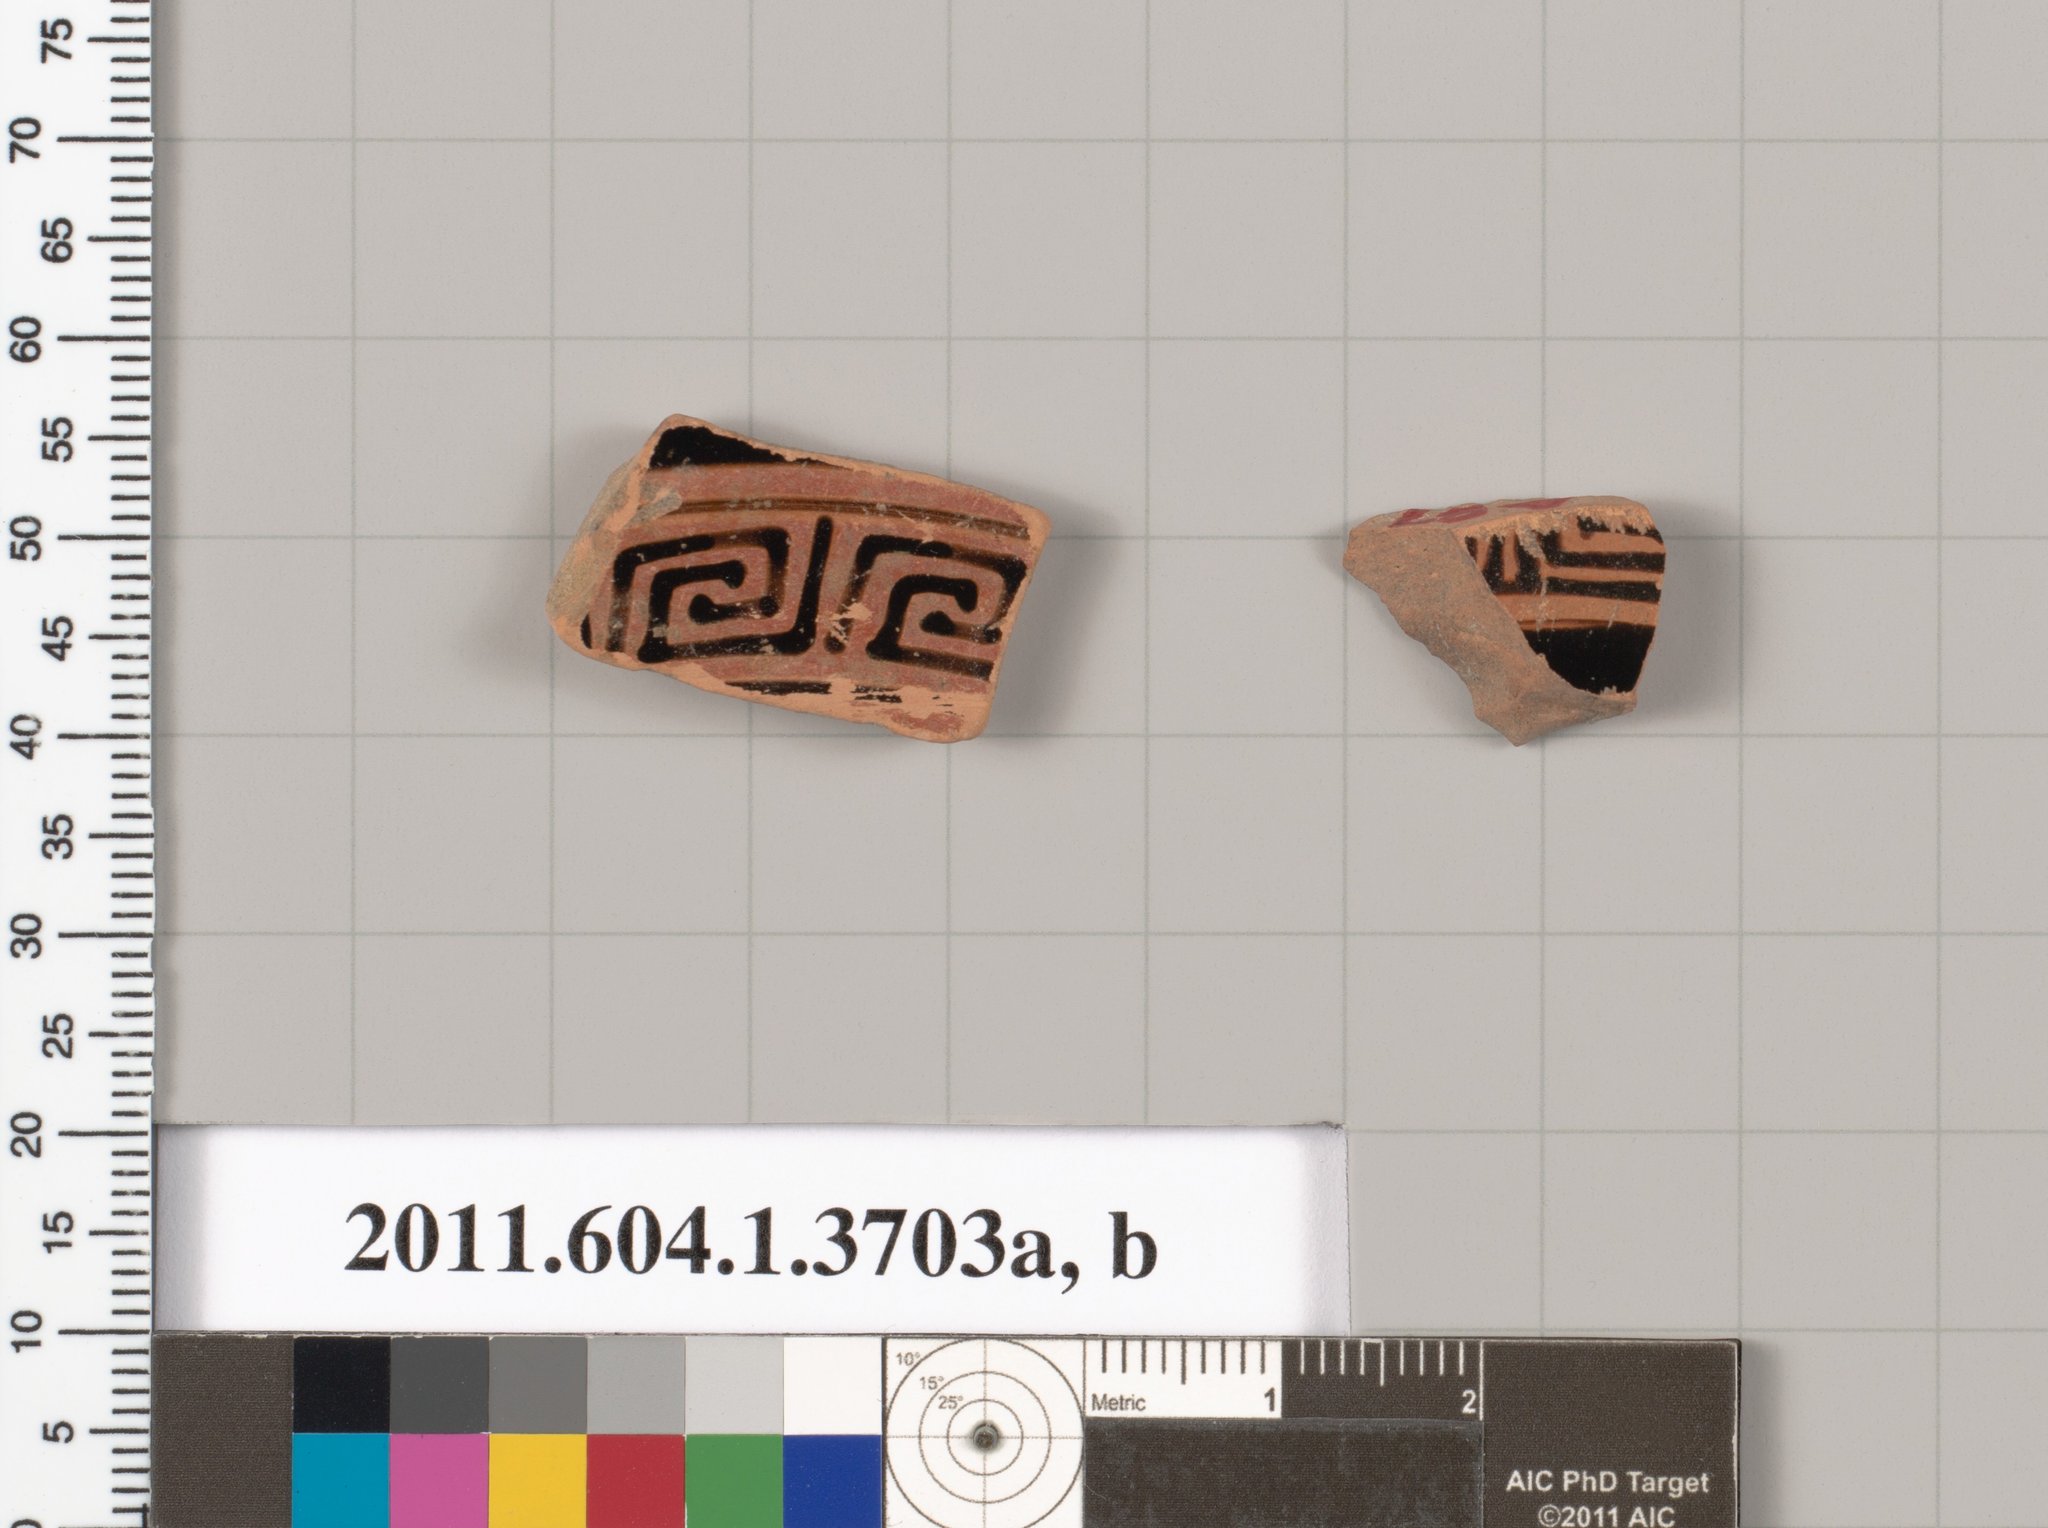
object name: kylix fragment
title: Terracotta fragments of kylikes (drinking cups)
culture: greek, attic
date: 500-470 BCE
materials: terracotta